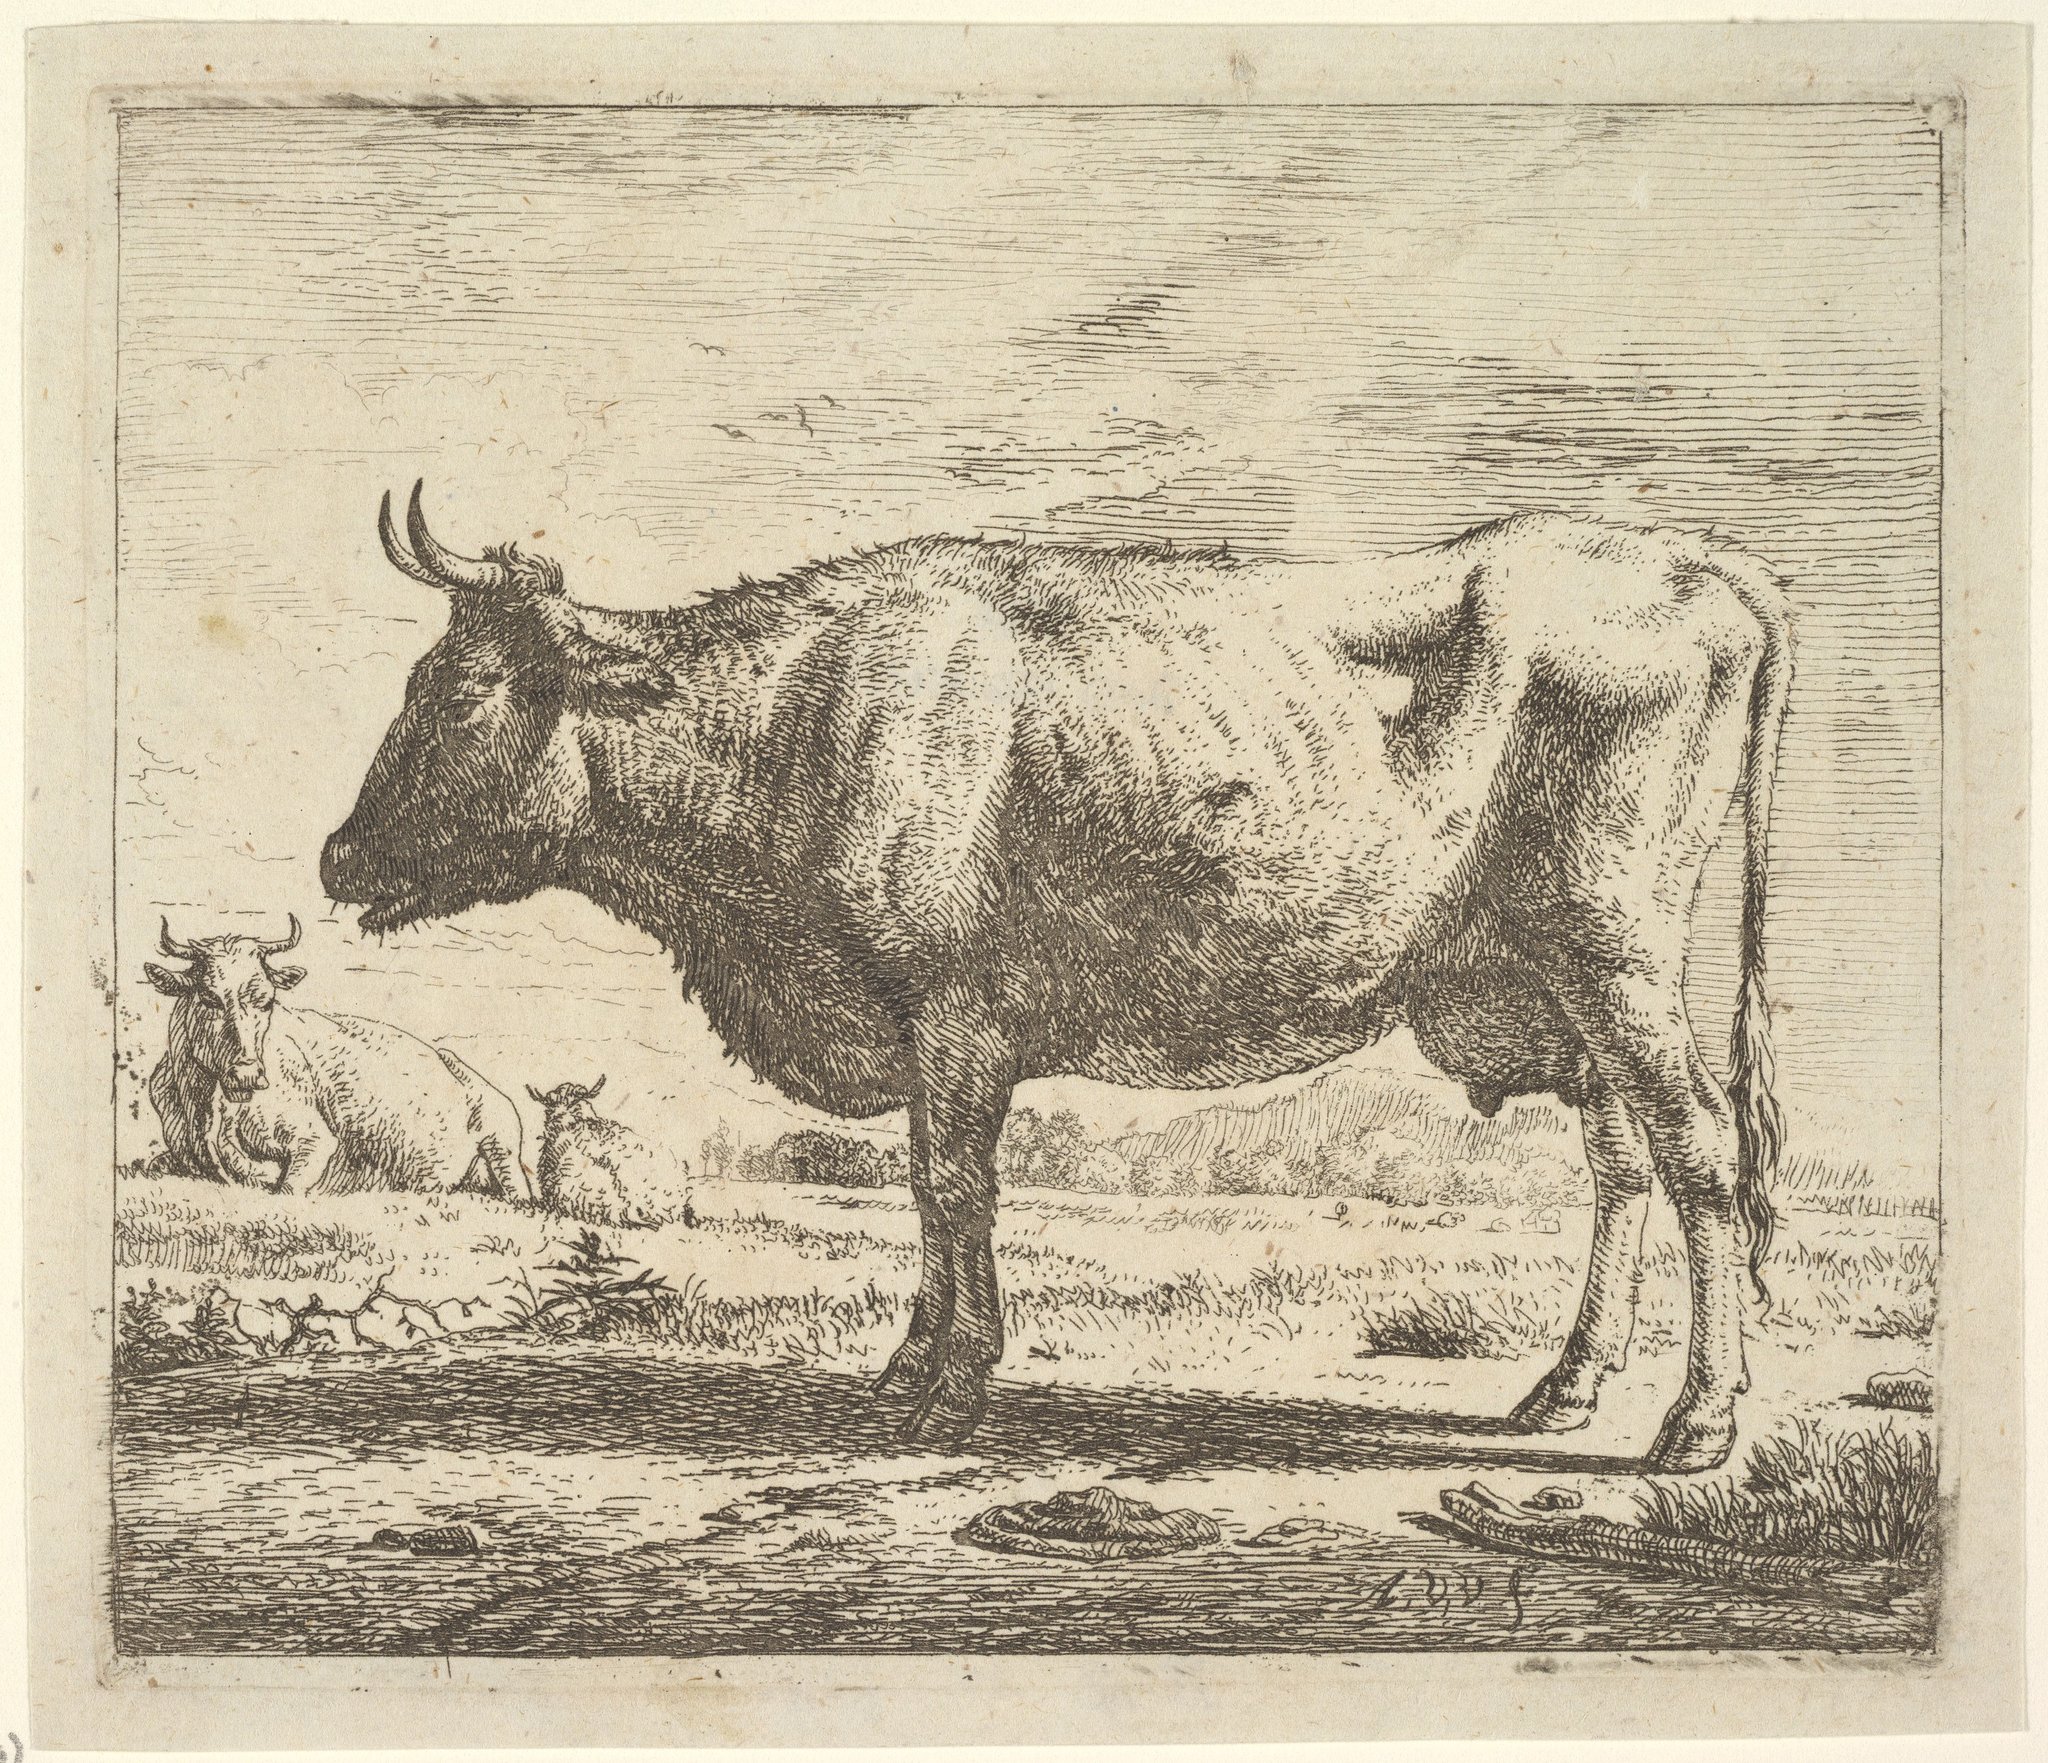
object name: print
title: Two Cows and a Sheep, plate 4 from "Different Animals"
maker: adriaen van de velde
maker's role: artist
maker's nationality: dutch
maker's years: 1636-1672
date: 1650-1672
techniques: etching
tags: cows